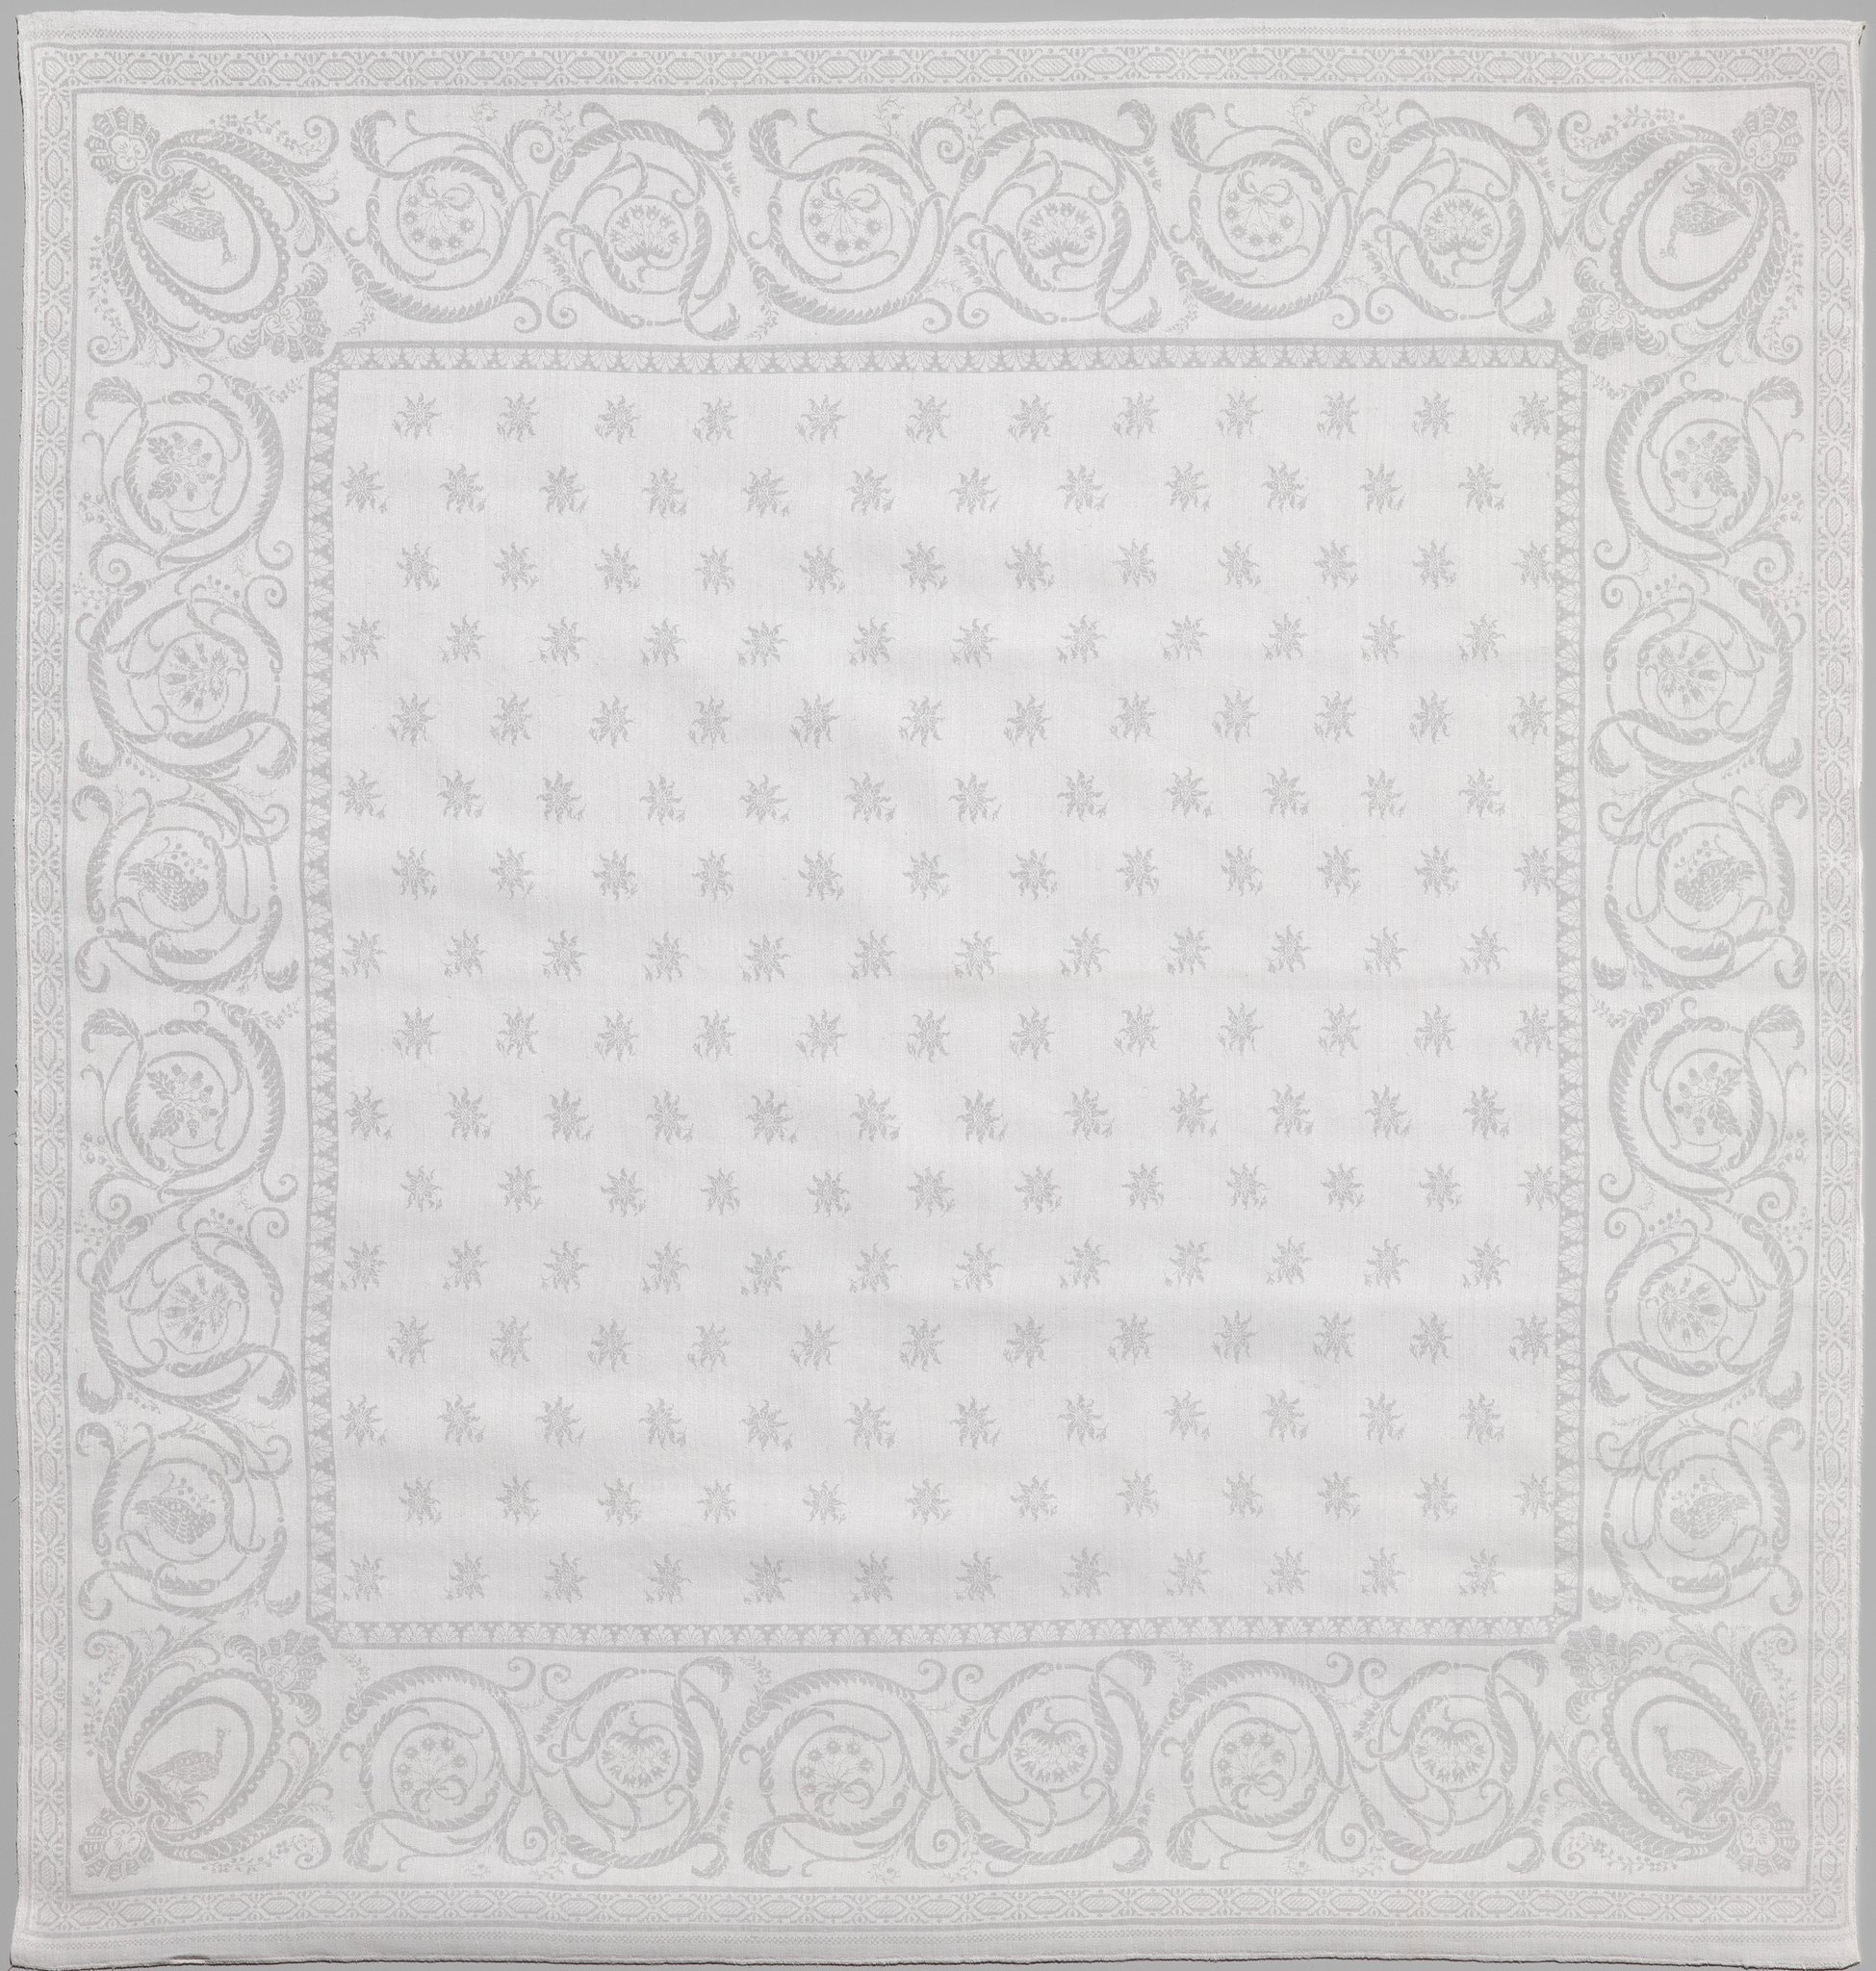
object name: napkin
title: Servet van linnendamast met een bloempatroon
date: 1800-1825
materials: linen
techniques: damask, weave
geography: netherlands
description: Servet van linnendamast met gestrooide bloemen en een voluutrand met vogels. Bij het servet horen zeven servetten (BK-1976-119-A t/m BK-1976-119-H) en een tafellaken (BK-1979-118).